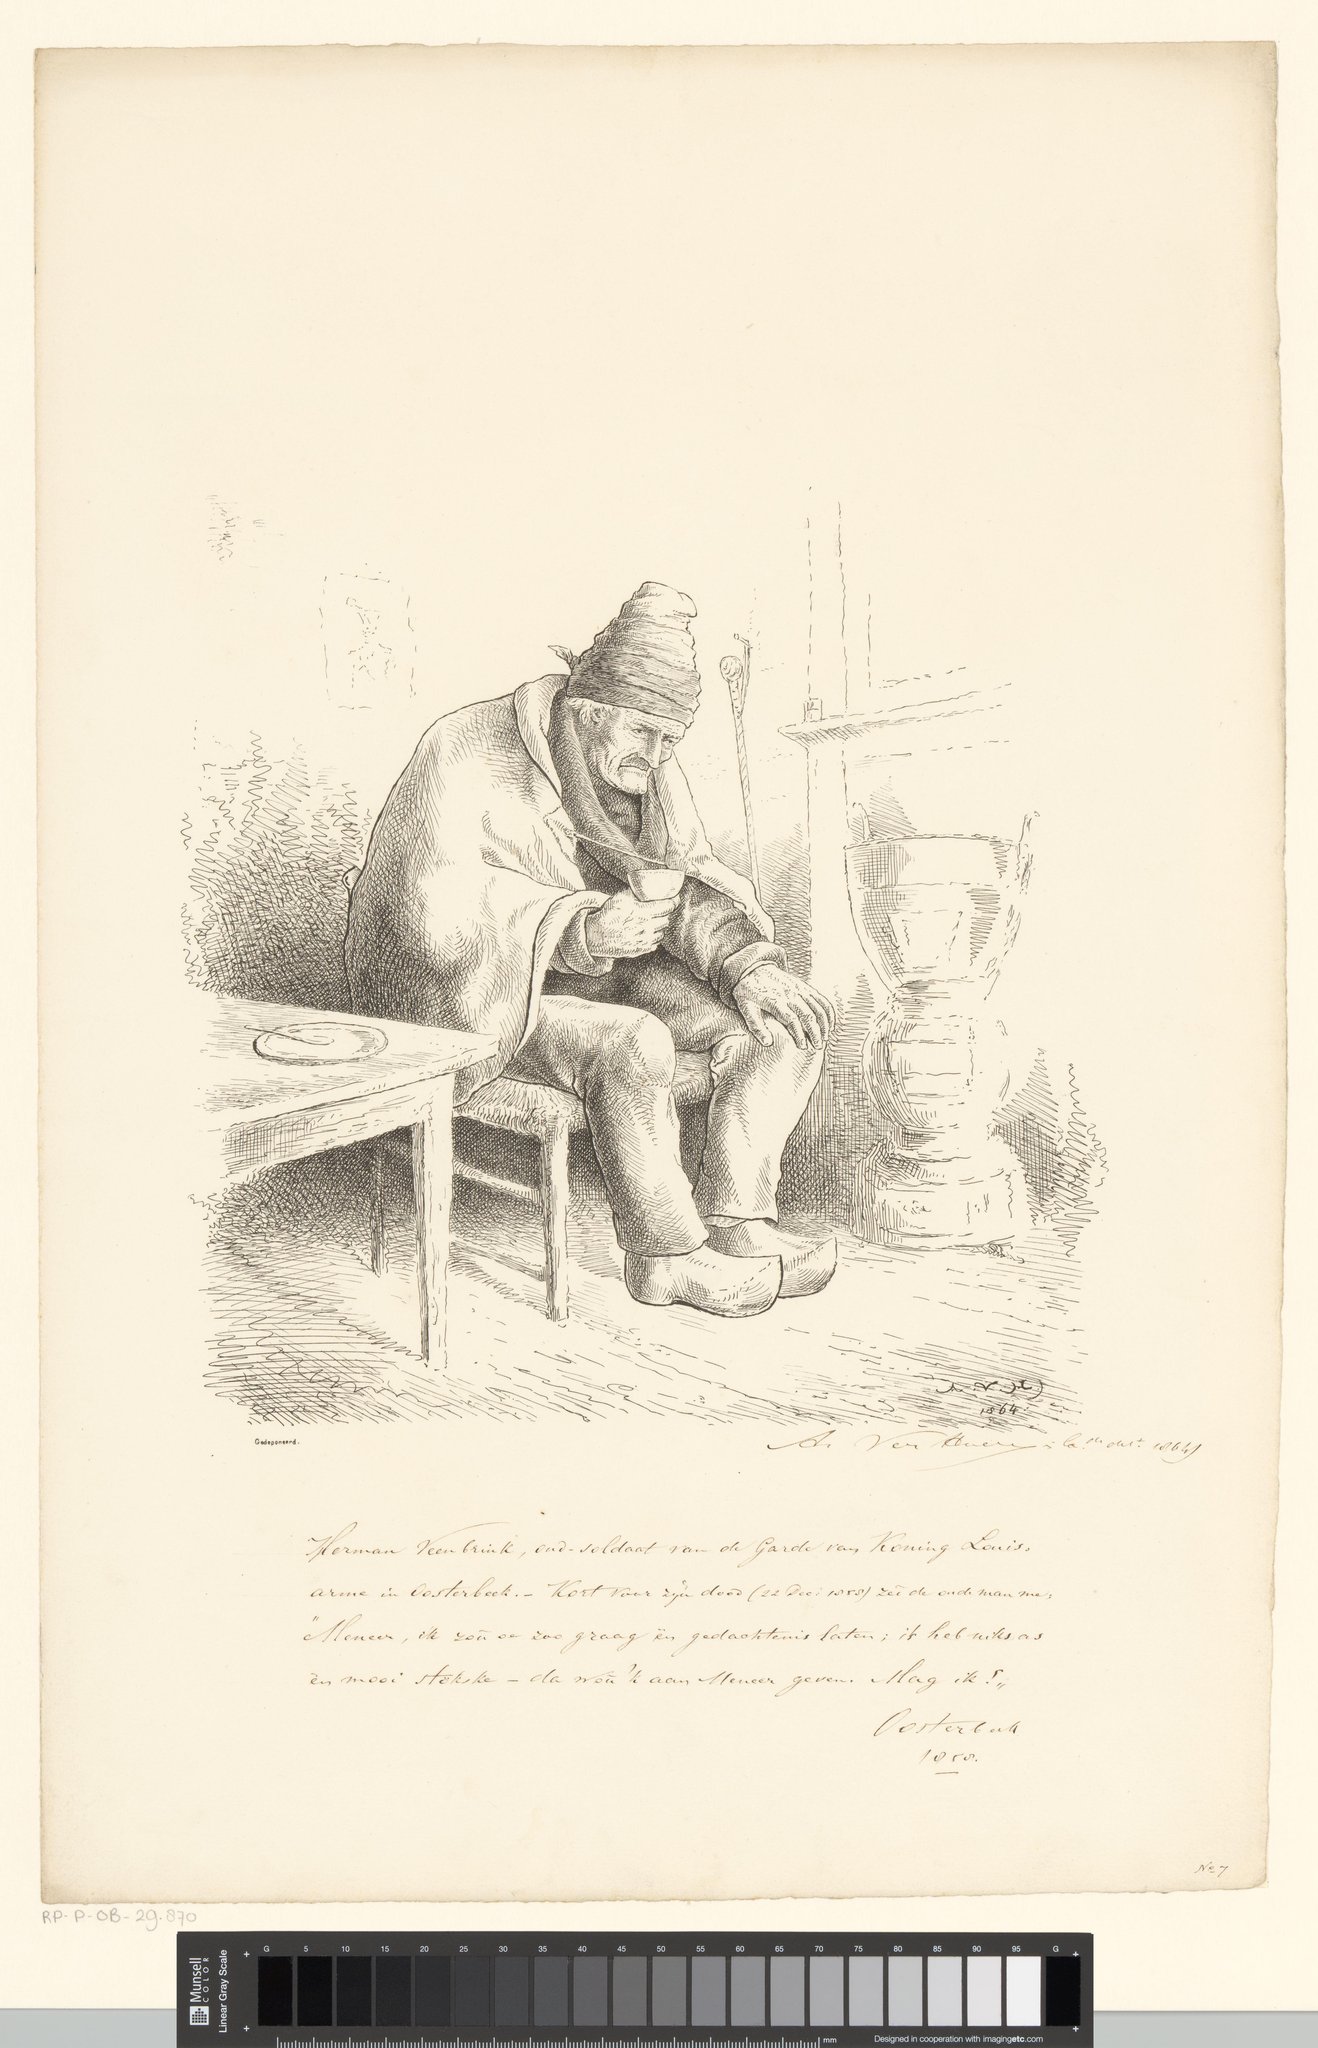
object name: print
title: Uit het verleden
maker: alexander ver huell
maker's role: draughtsman, print maker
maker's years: 1822-1897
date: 1864-1866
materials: paper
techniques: lithograph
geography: arnhem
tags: old man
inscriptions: collector's mark: Lugt 2228, : ‘Gedeponeerd.’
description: Een oude man, Herman Veenbrink, zit voorovergebogen op een stoel. In zijn hand houdt hij een beker.